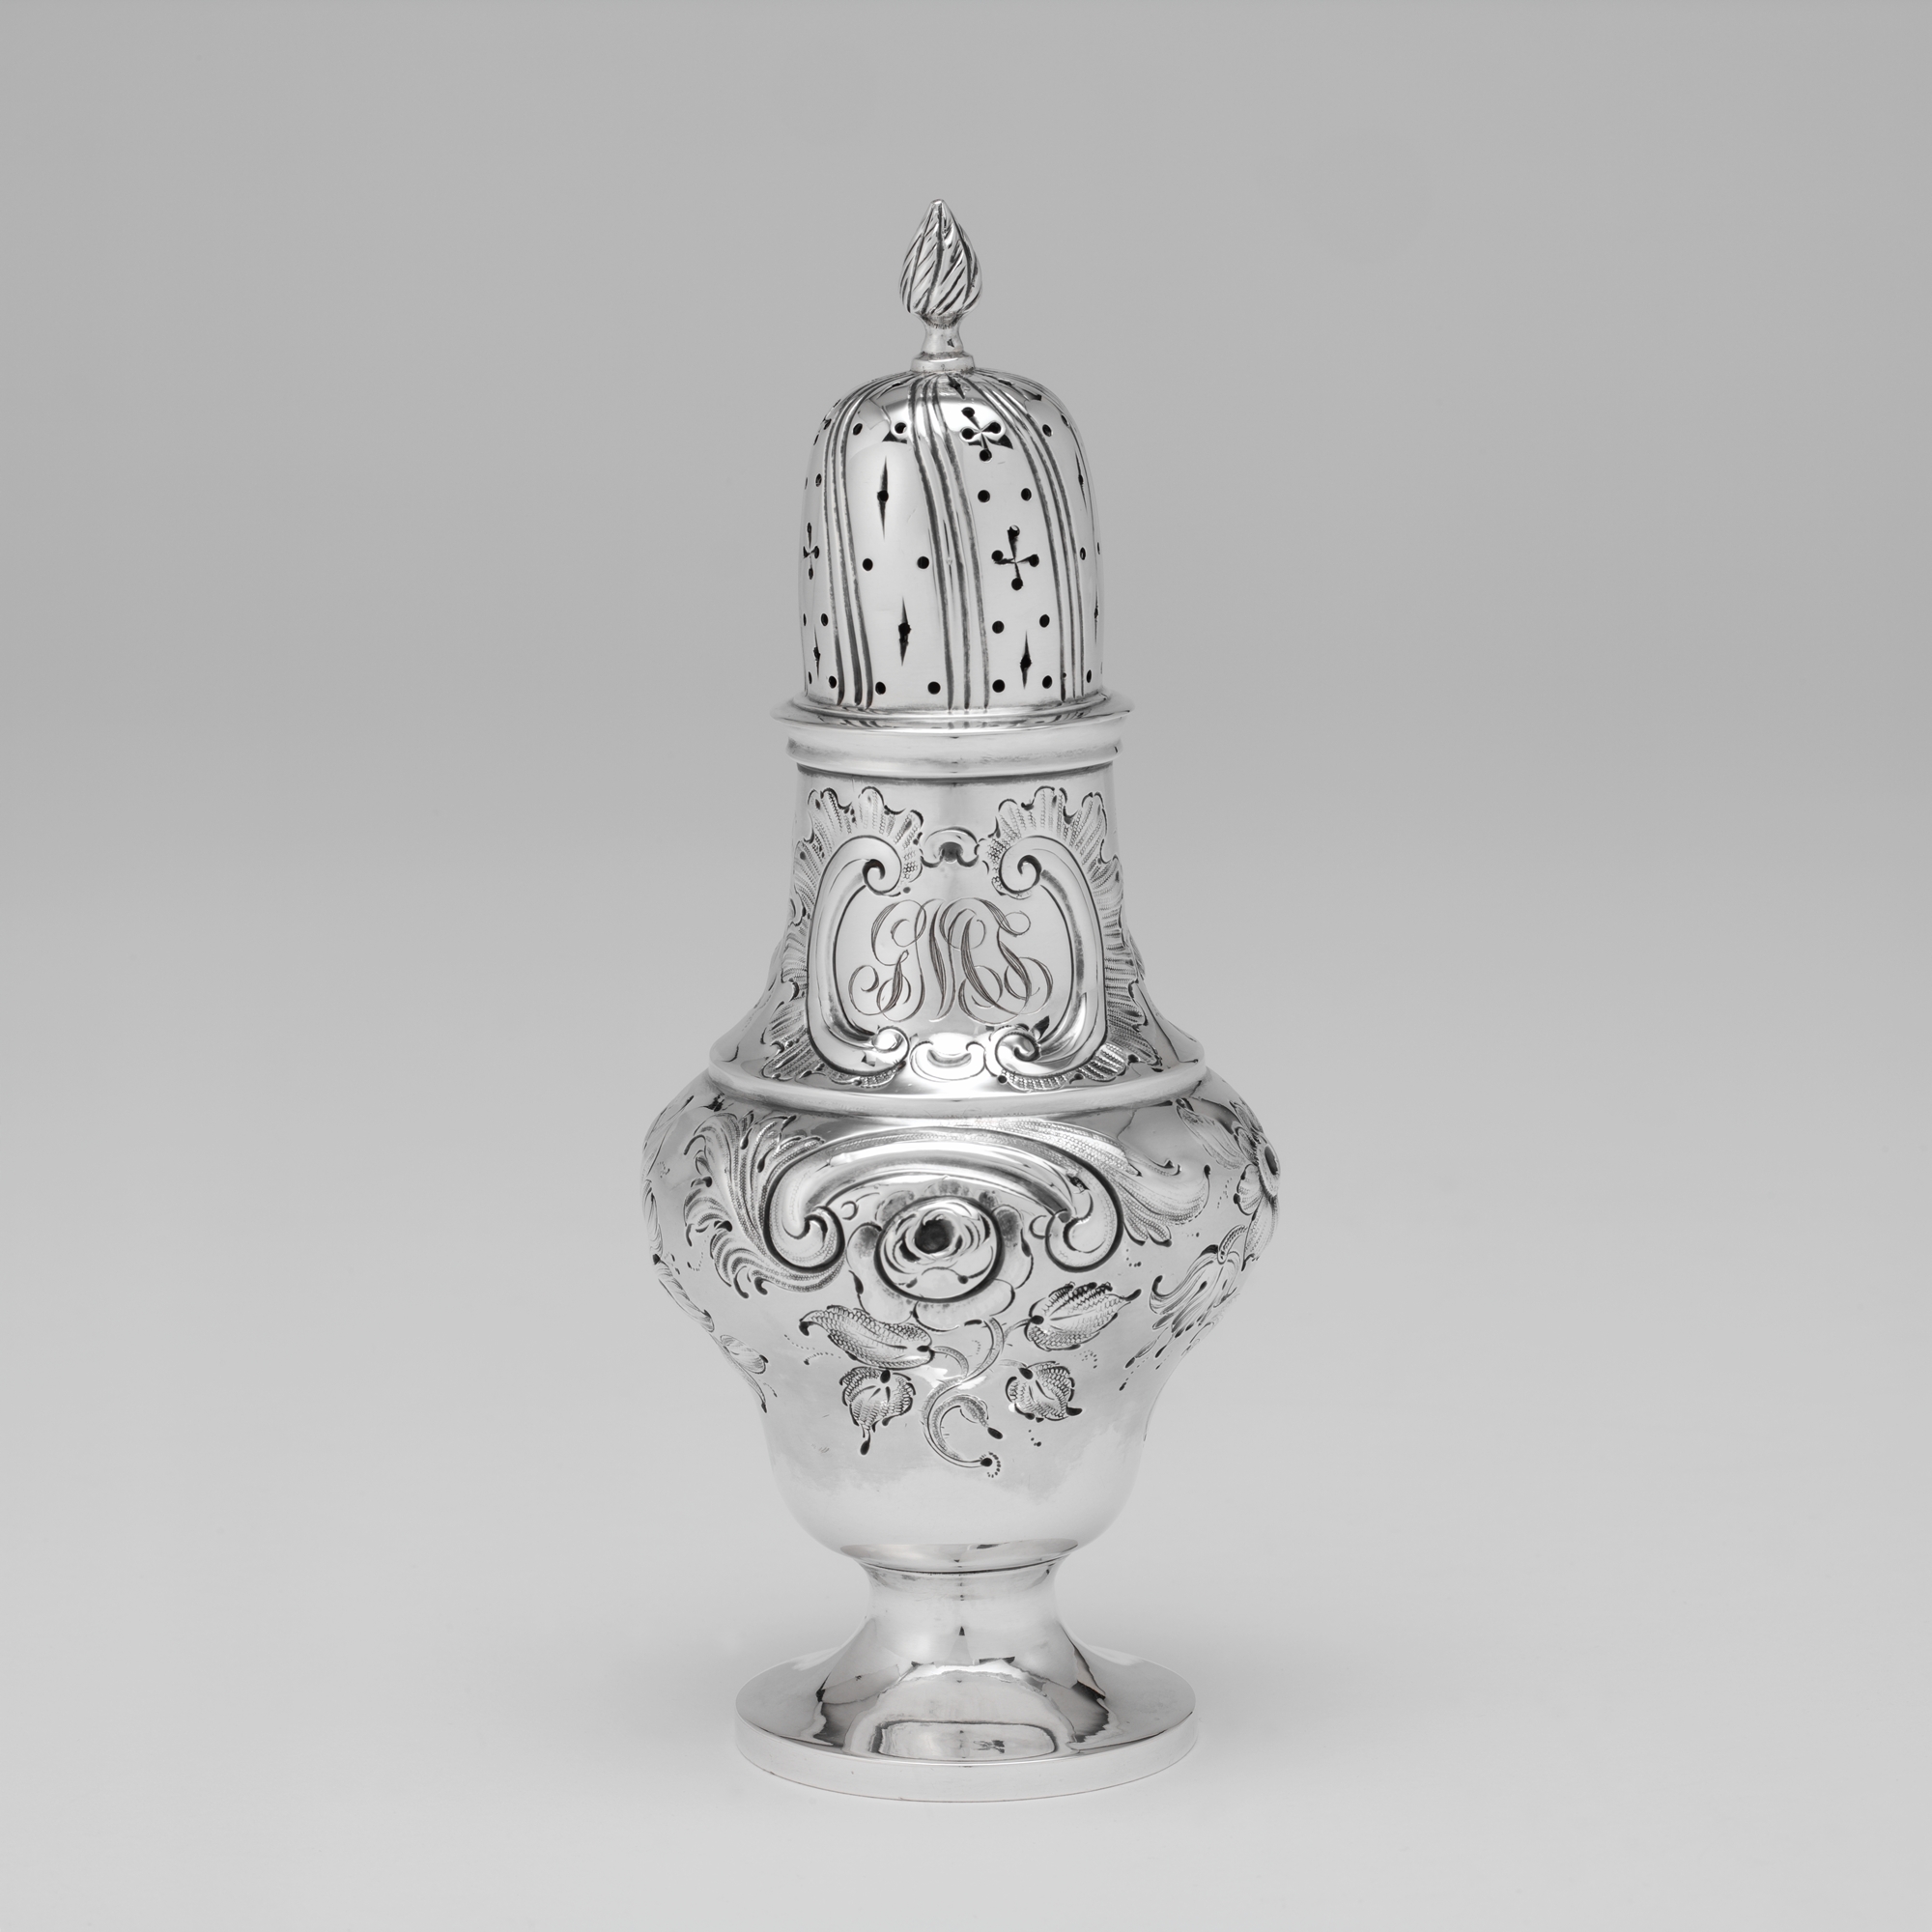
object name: caster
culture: american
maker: william forbes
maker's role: maker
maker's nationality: american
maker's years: 1826-1863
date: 1840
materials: silver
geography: united states